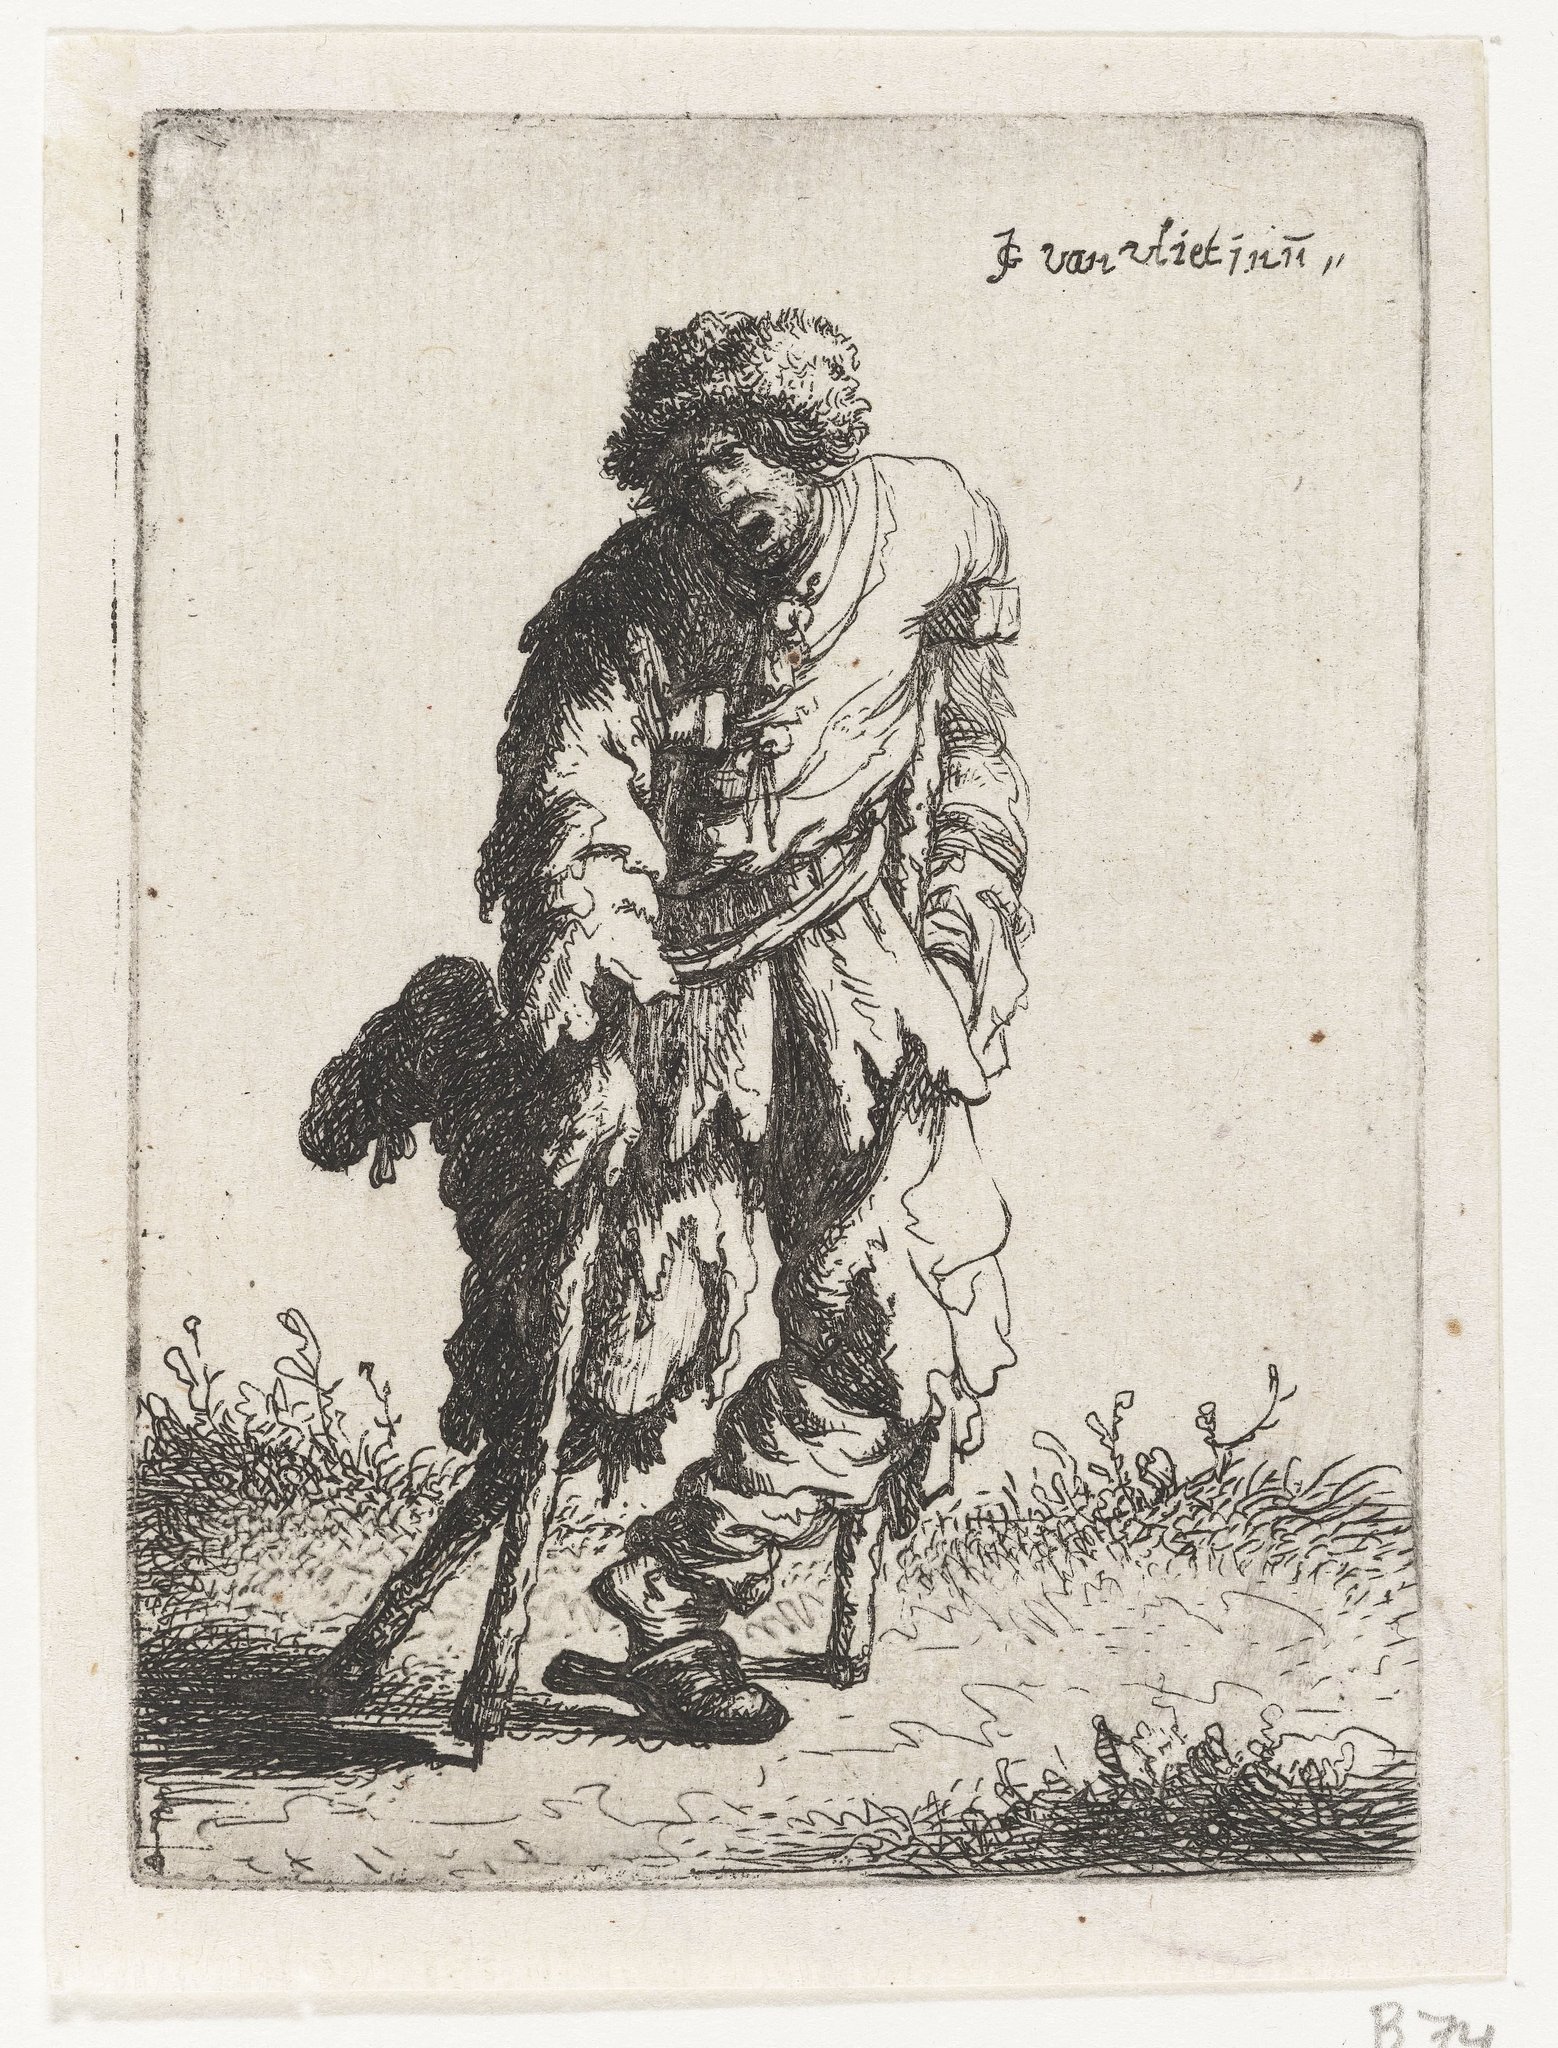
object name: print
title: Bedelaars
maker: jan gillisz. van vliet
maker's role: draughtsman, painter, print maker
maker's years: 1600-1668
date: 1632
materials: paper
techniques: etching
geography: leiden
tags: crutches, wooden leg, beggar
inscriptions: collector's mark: Lugt 240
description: Een bedelaar met een houten been en op krukken loopt naar rechts.